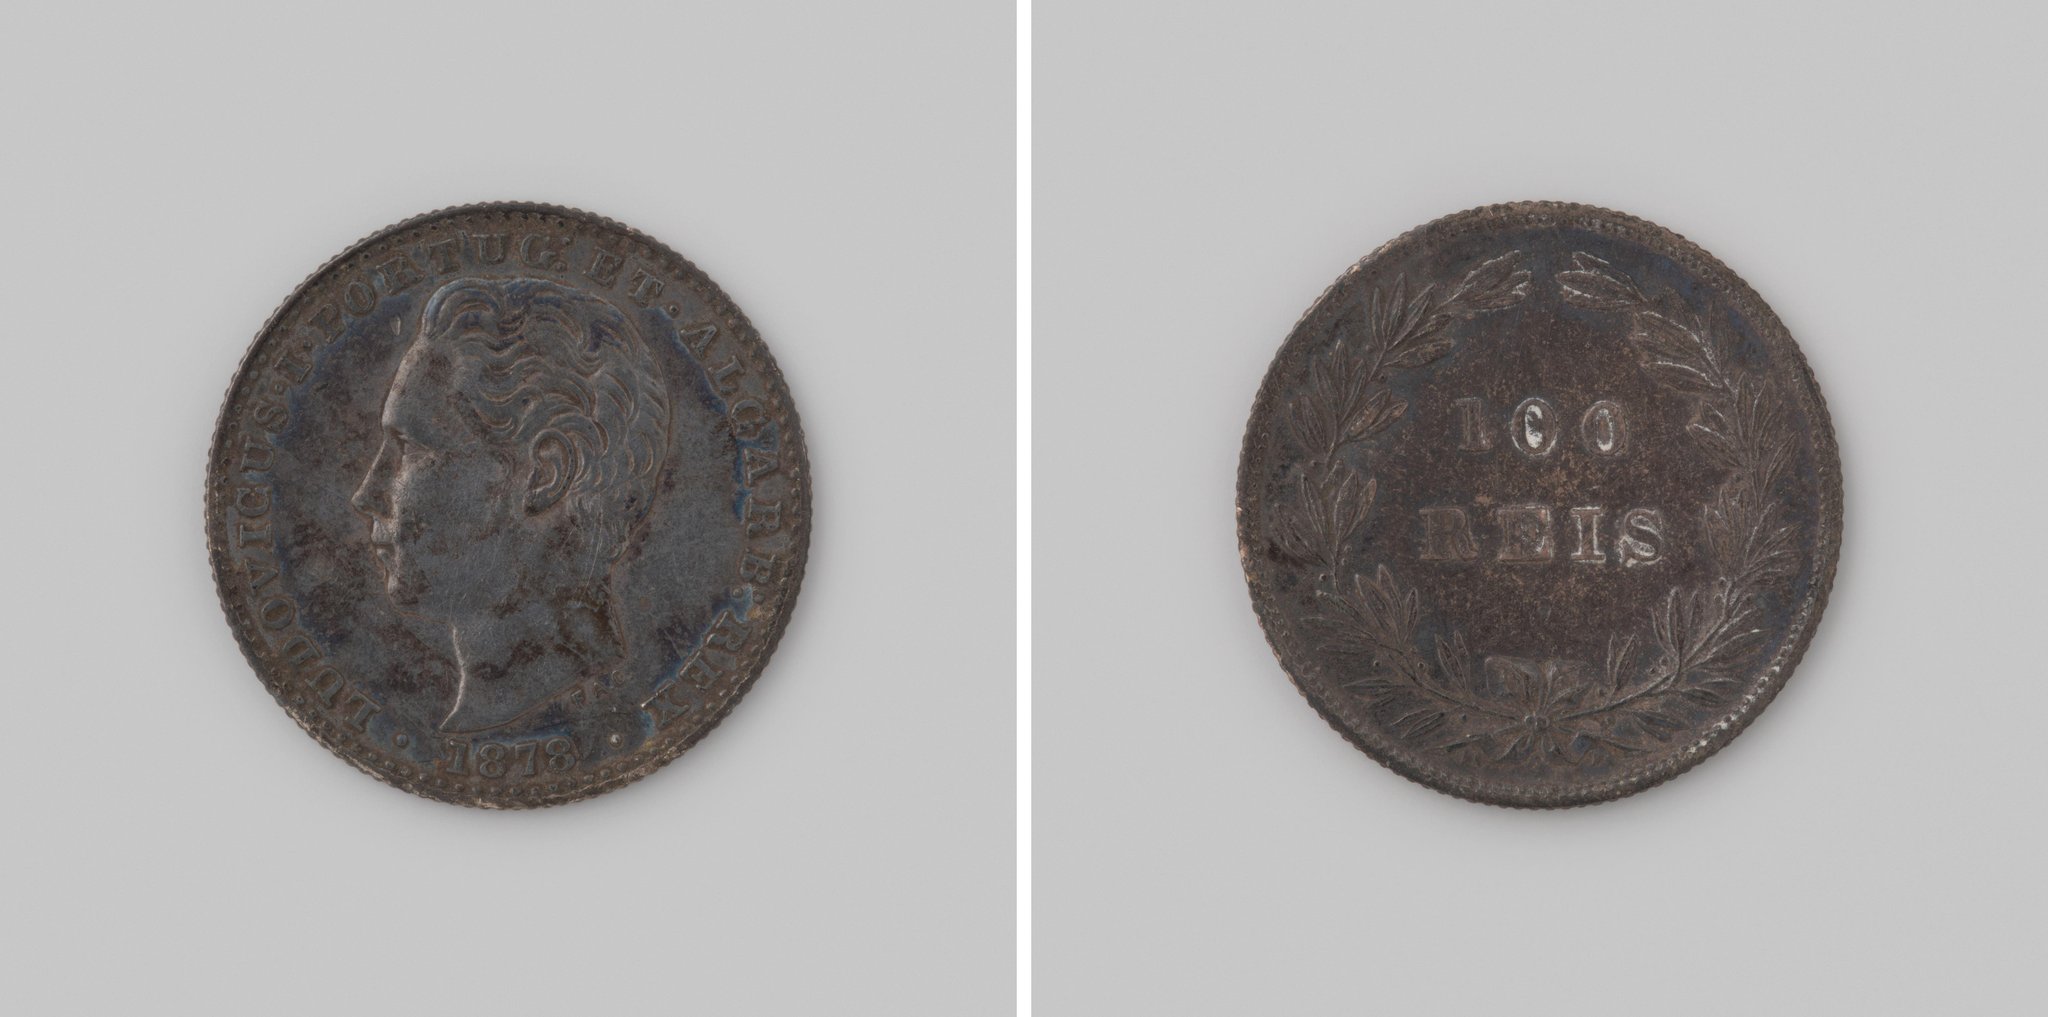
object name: coin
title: Tostao of 100 reis uit Portugal van koning Luiz I, 1878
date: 1878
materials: silver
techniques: striking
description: Zilveren munt. Voorzijde: hoord van de koning naar links. Daaronder jaartal. Keerzijde: tussen twee samengebonden takken waarde-aanduiding in twee regels. Kartelrand.